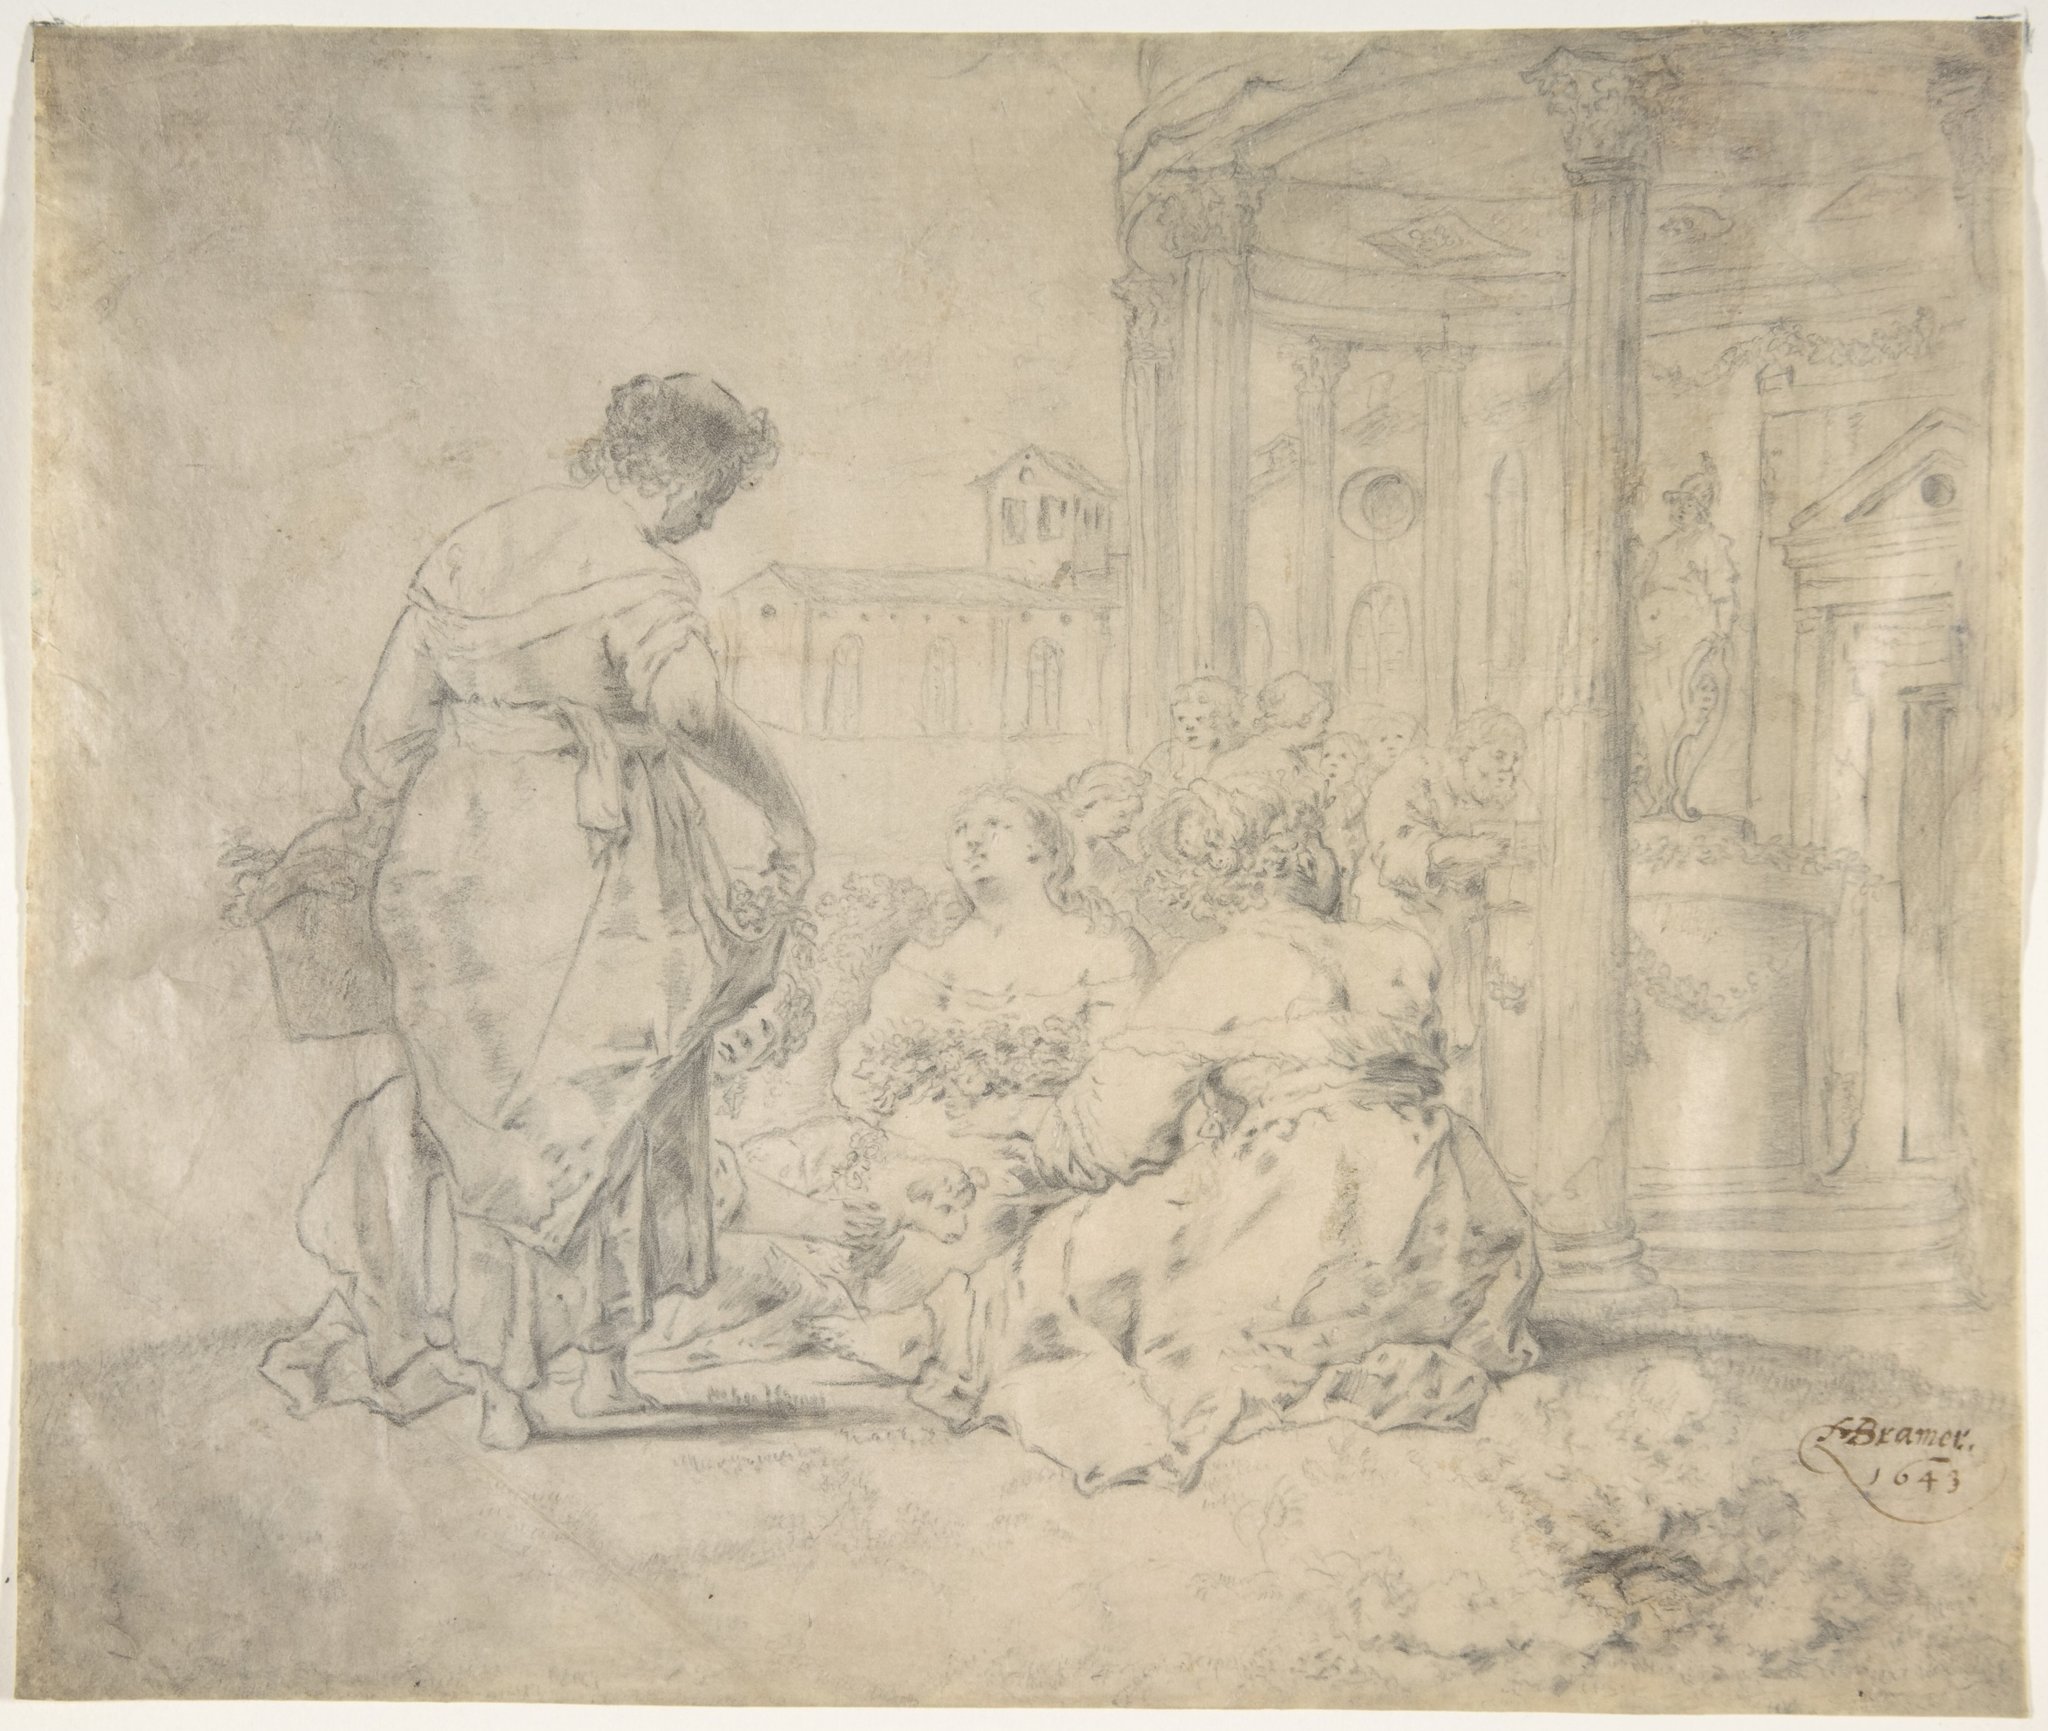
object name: drawing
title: Preparation for Sacrifice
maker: leonaert bramer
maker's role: artist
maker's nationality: dutch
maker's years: 1596-1674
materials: graphite, parchment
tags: women